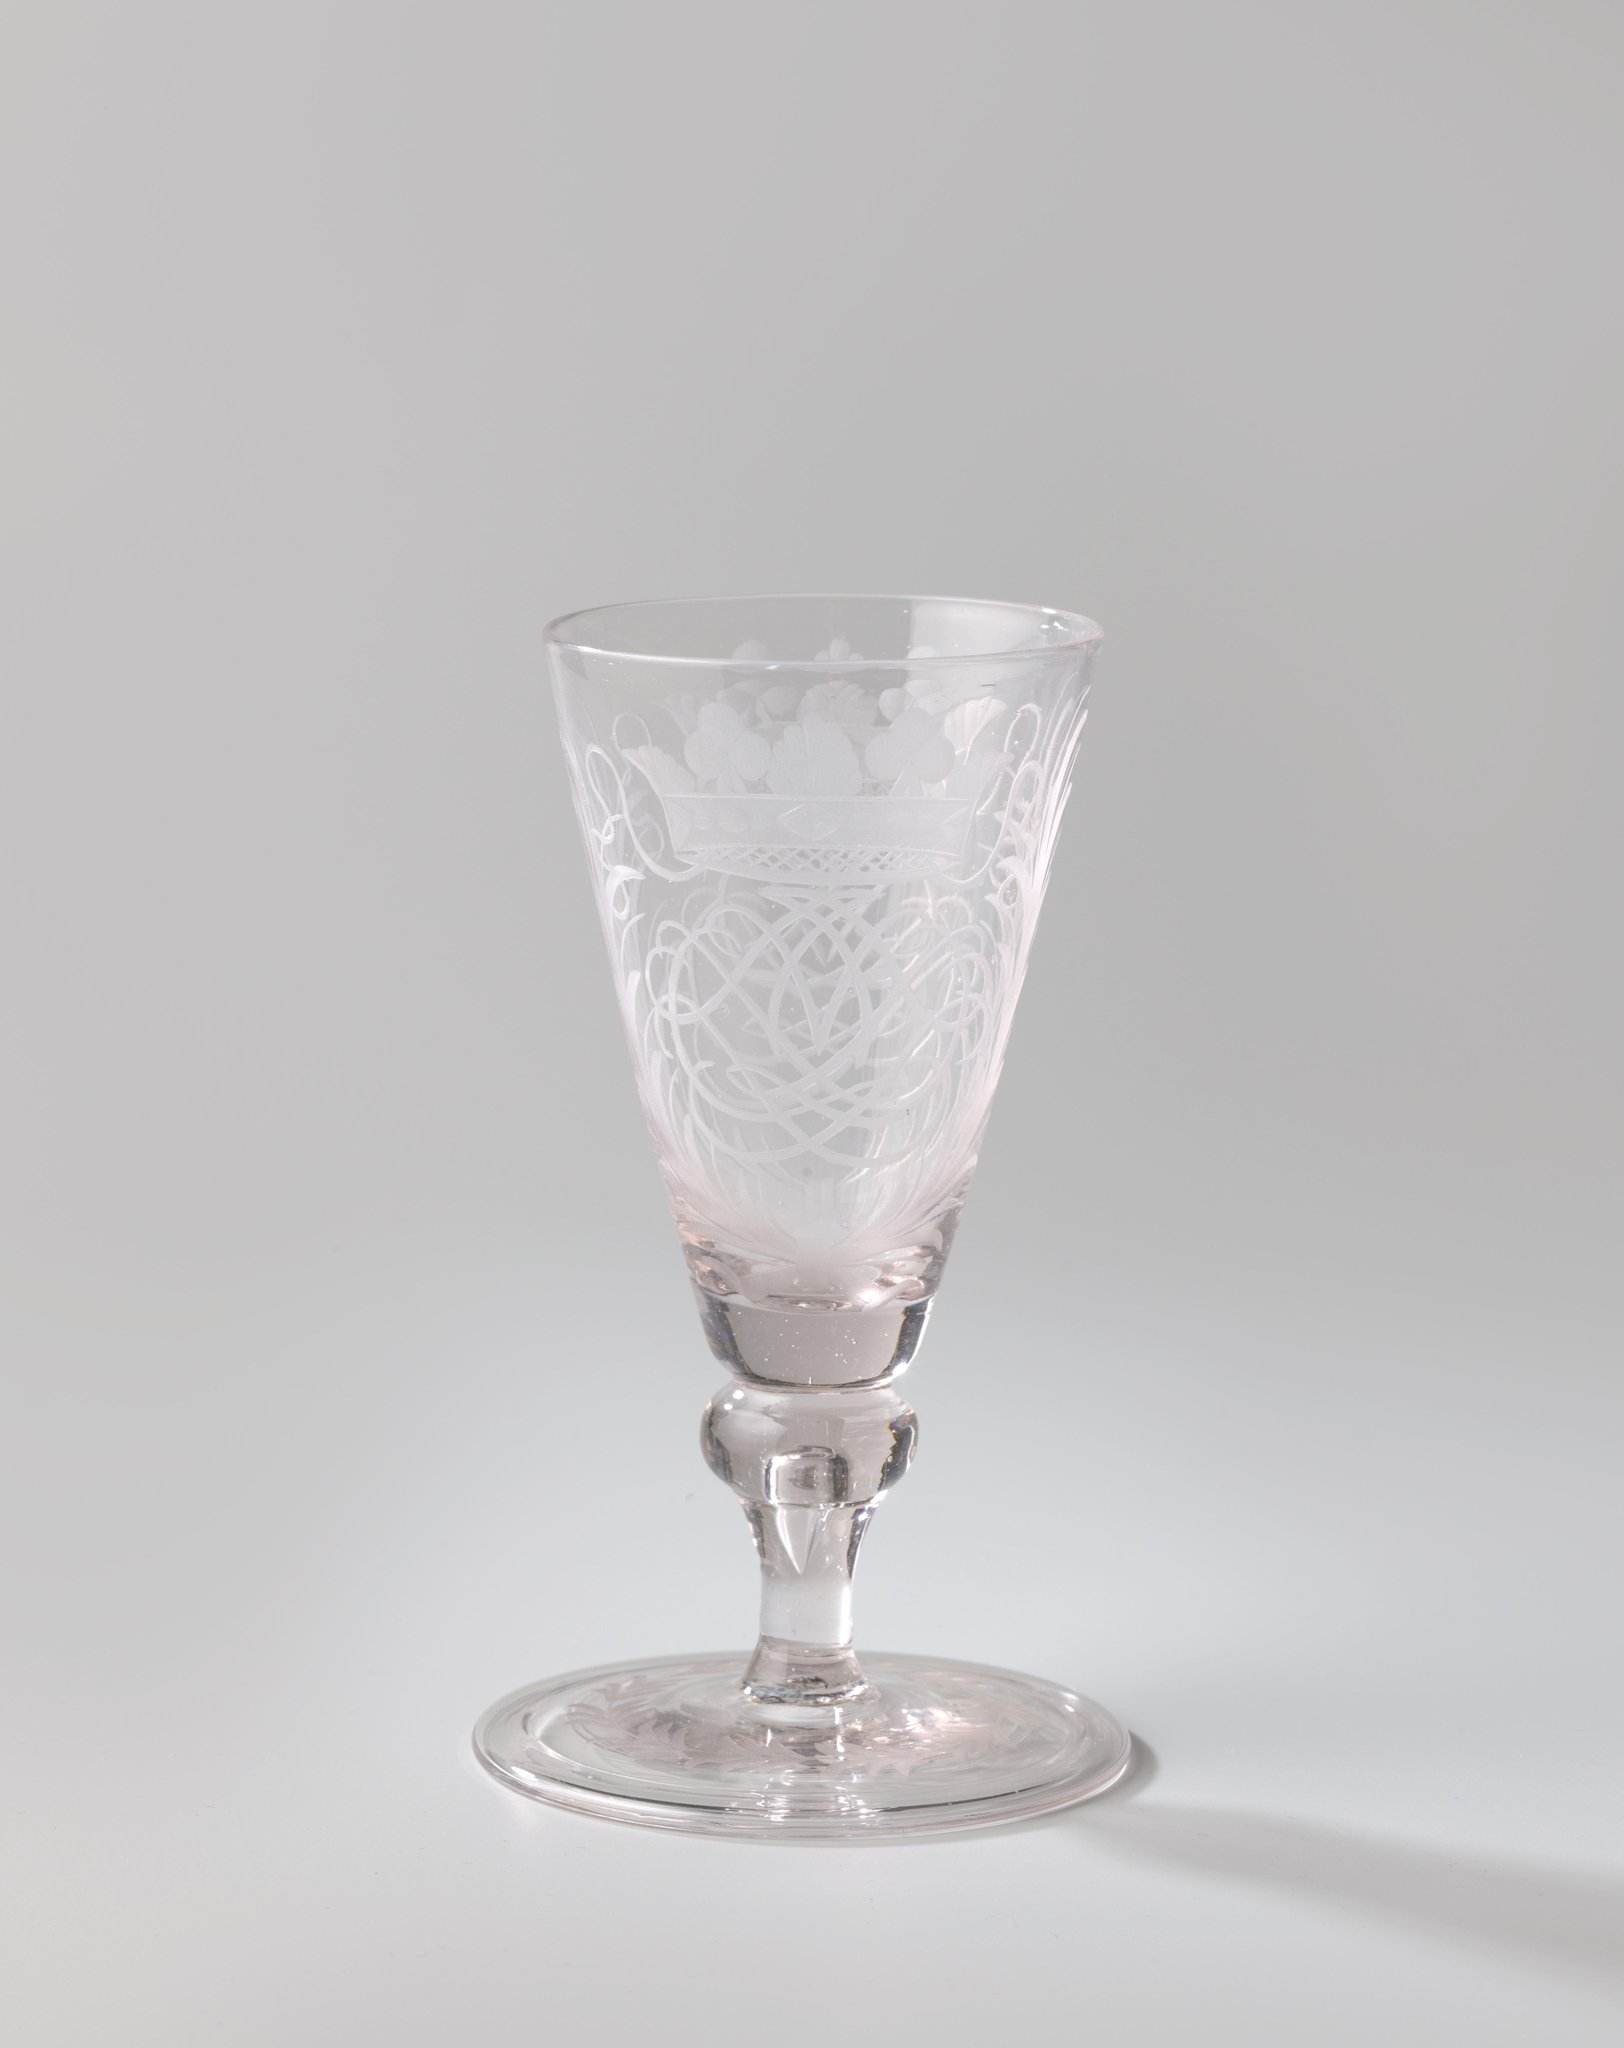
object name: goblet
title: Kelkglas met tweemaal het gekroonde monogram AVA tussen palmtakken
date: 1700-1725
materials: glass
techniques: glassblowing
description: Platte voet met omgeslagen rand. Korte balusterstam. Conische kelk met twee maal hetzelfde gekroonde monogram AVA tussen palmtakken. Op de voet een bladkrans.